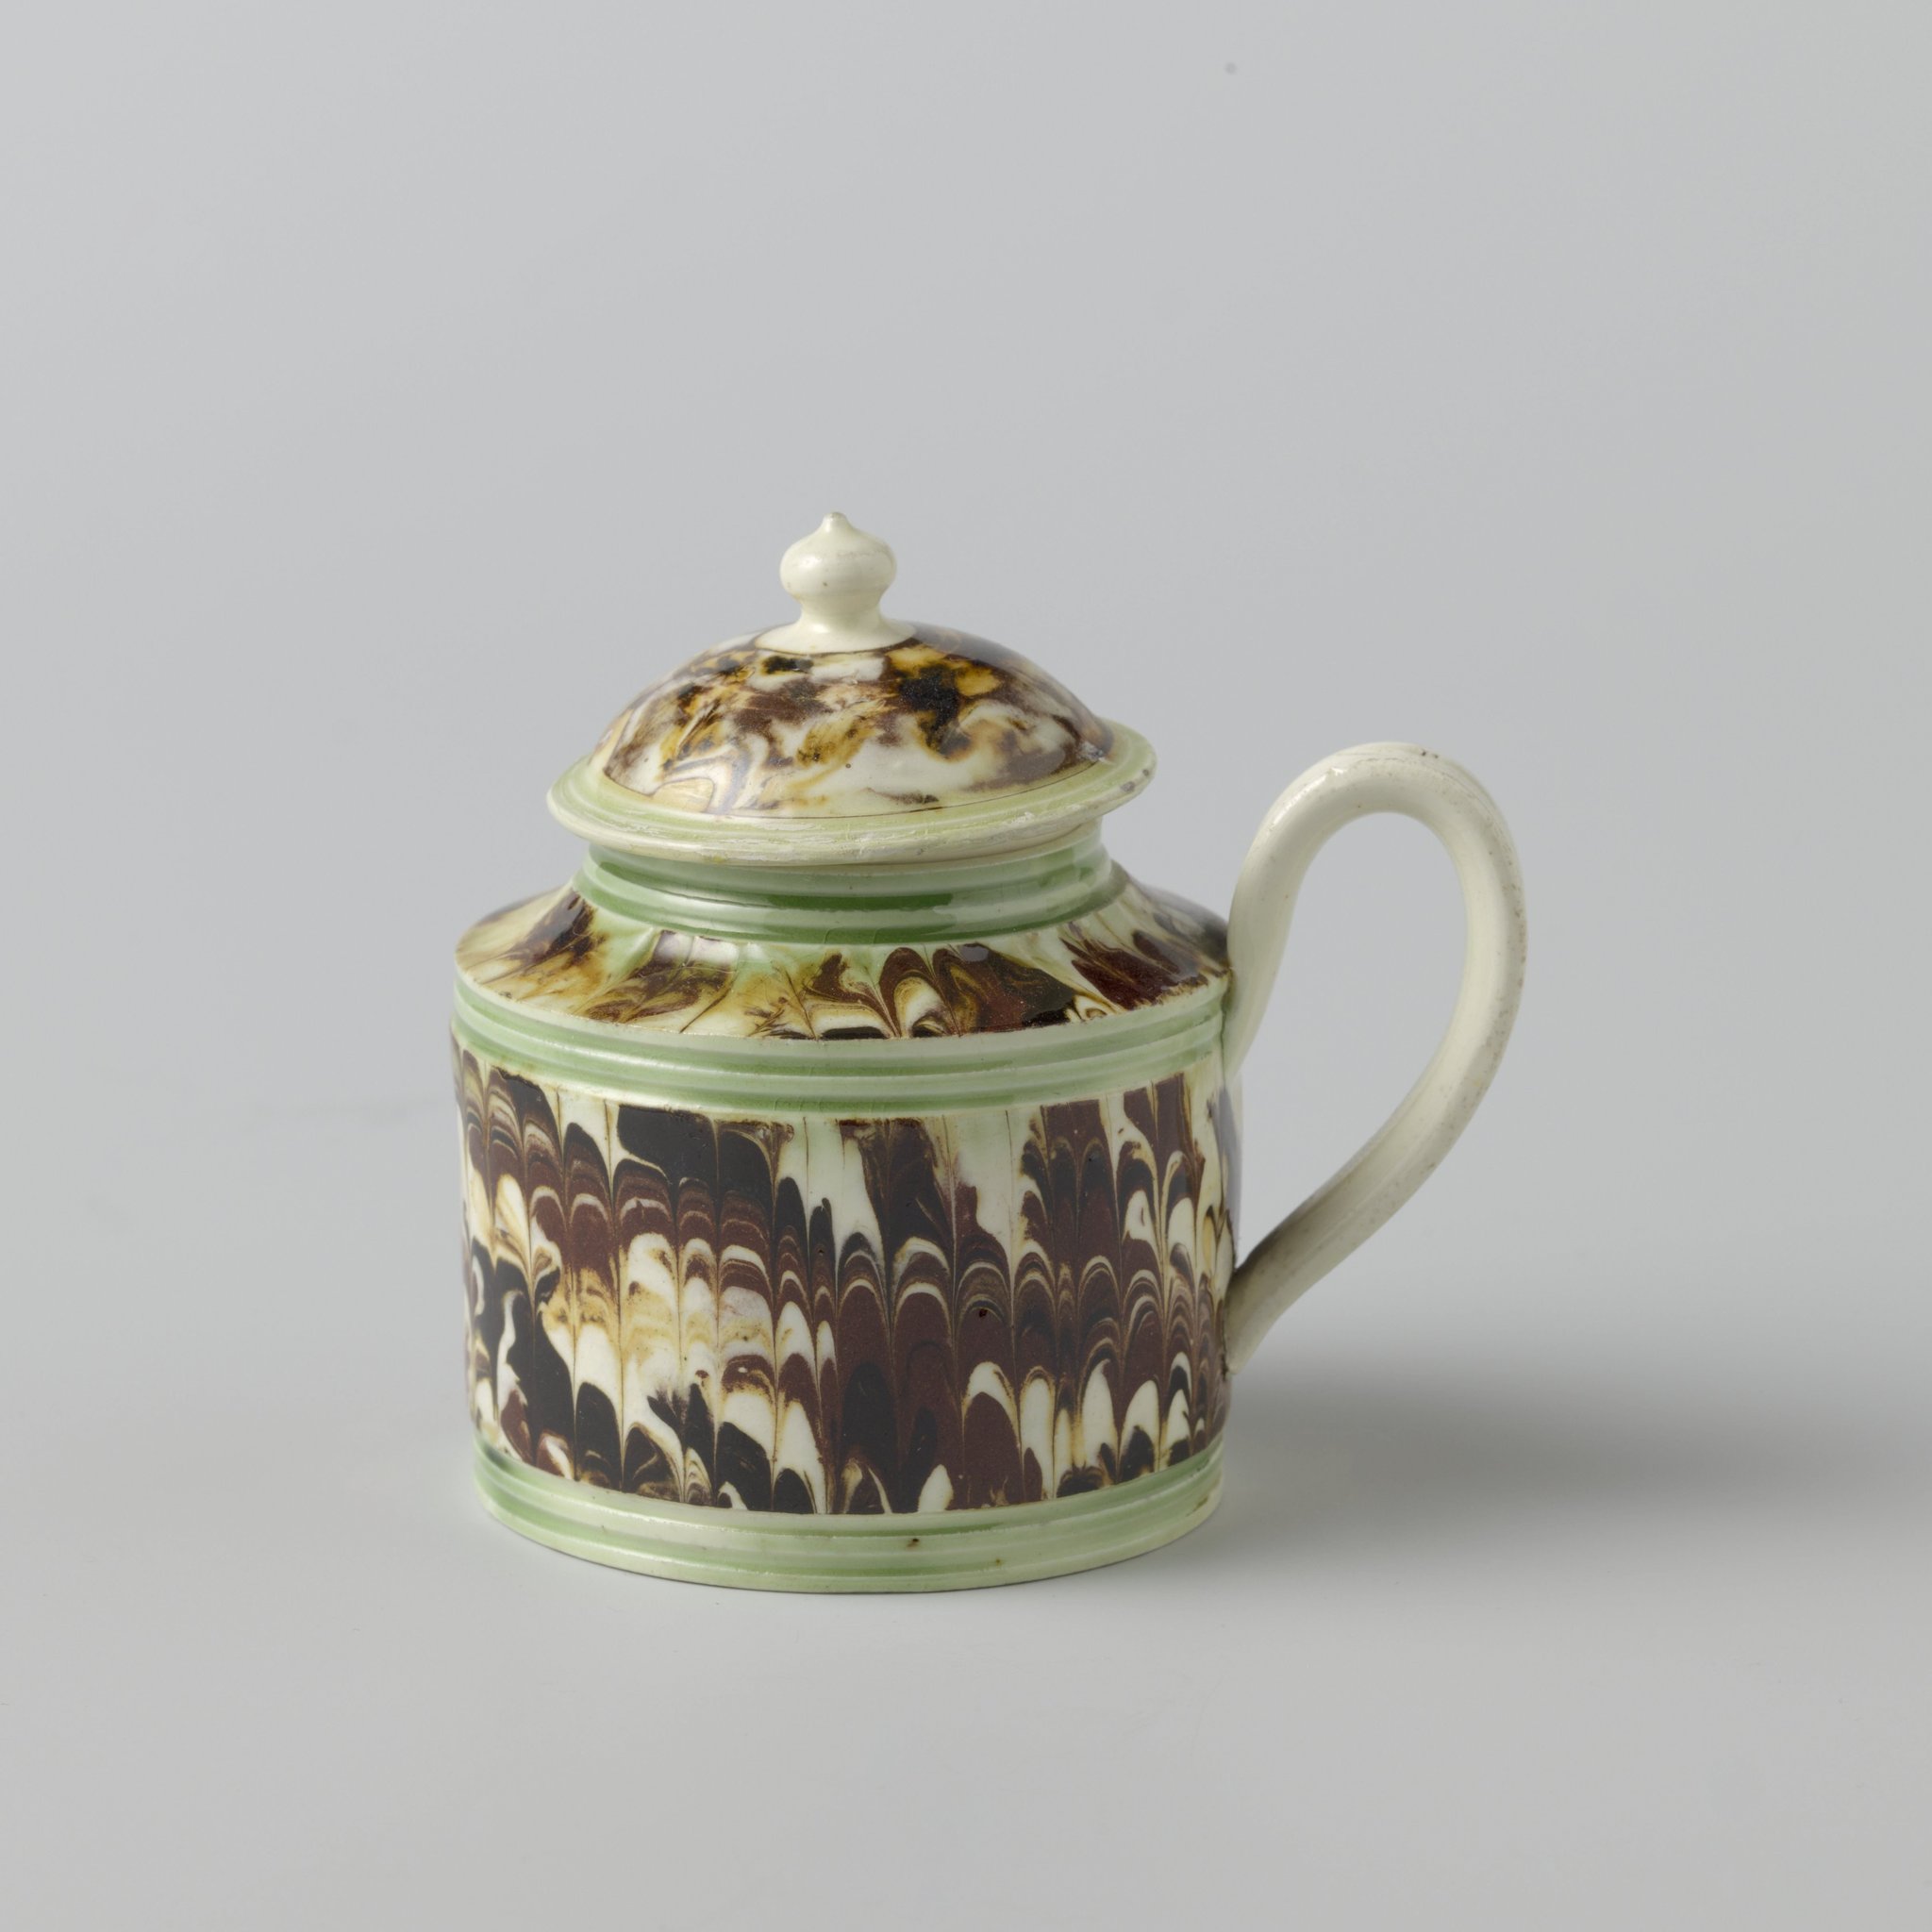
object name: mustard pot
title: Mosterdpot of roompot van hardgebakken aardewerk, creamware met gemarmerde decoratie.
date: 1778-1786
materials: earthenware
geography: staffordshire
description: Cilindrische mosterdpot of roompot van hardgebakken aardewerk. De pot heeft een smalle, lage hals waarop een gewelfd deksel met een knop, en een C-vormig oor. De pot heeft een gemarmerde decoratie in geel, bruin en zwart.